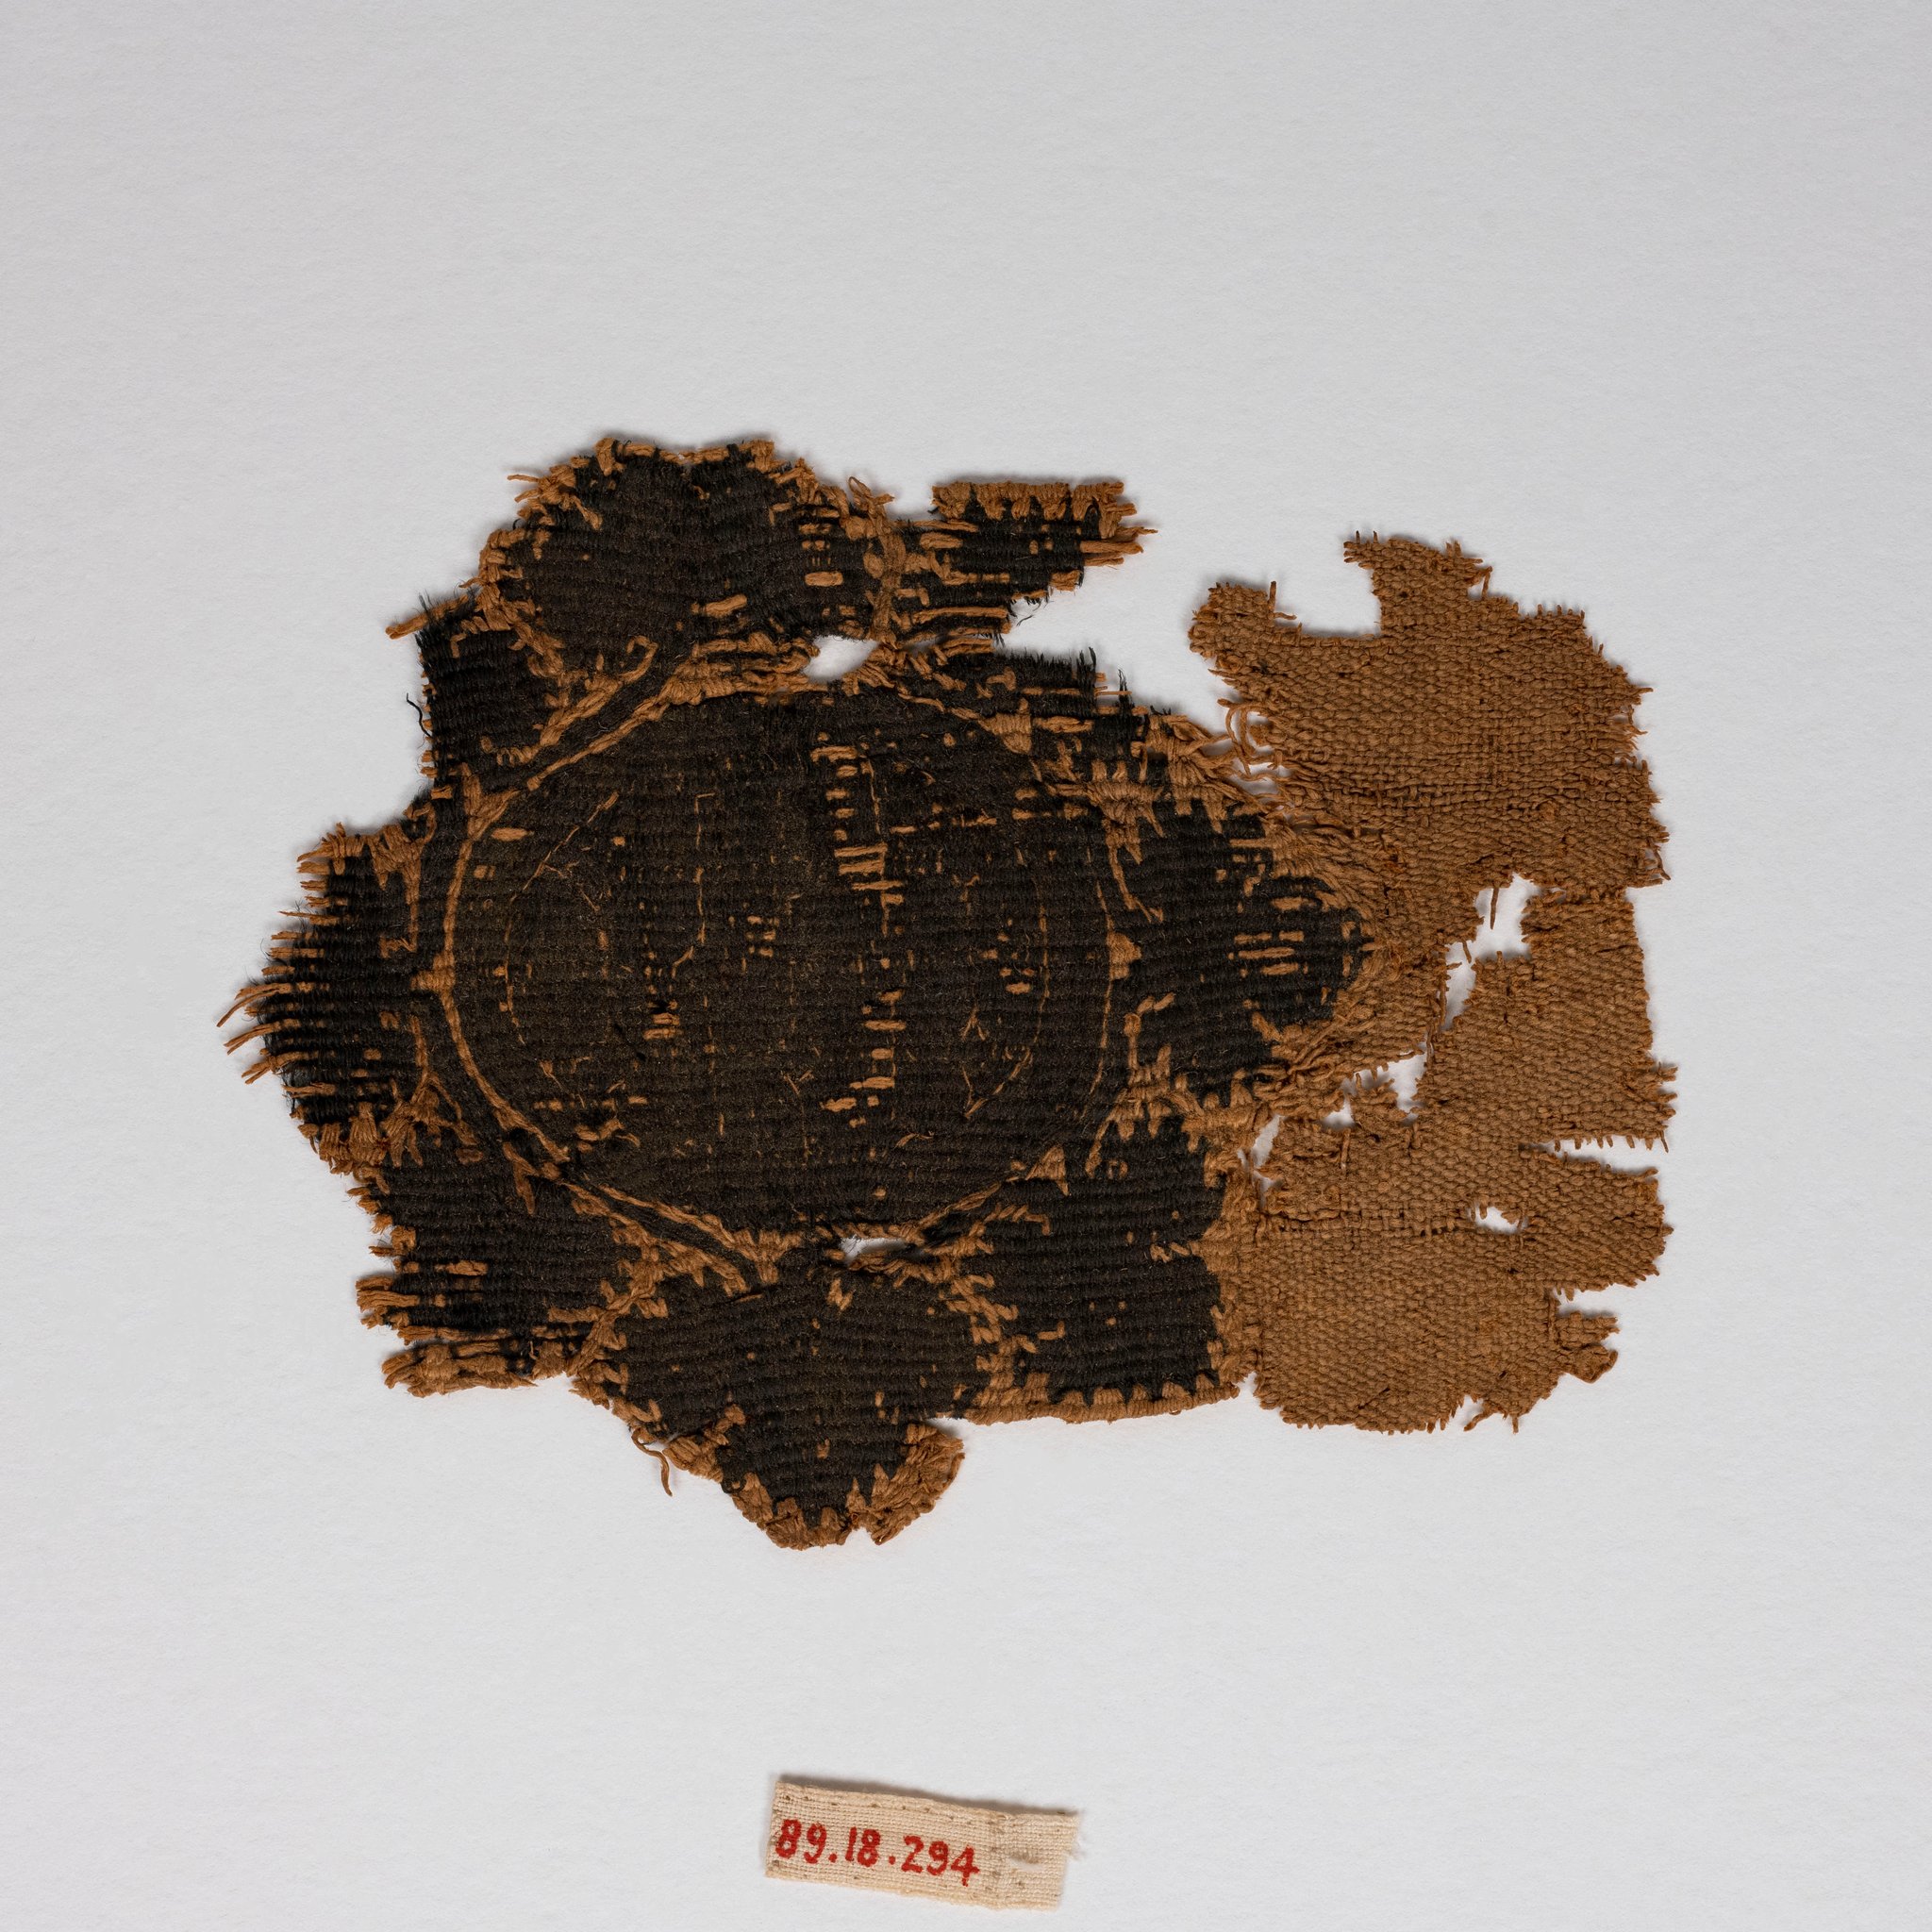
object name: textile fragment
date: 201-400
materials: linen, wool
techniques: weave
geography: egypt